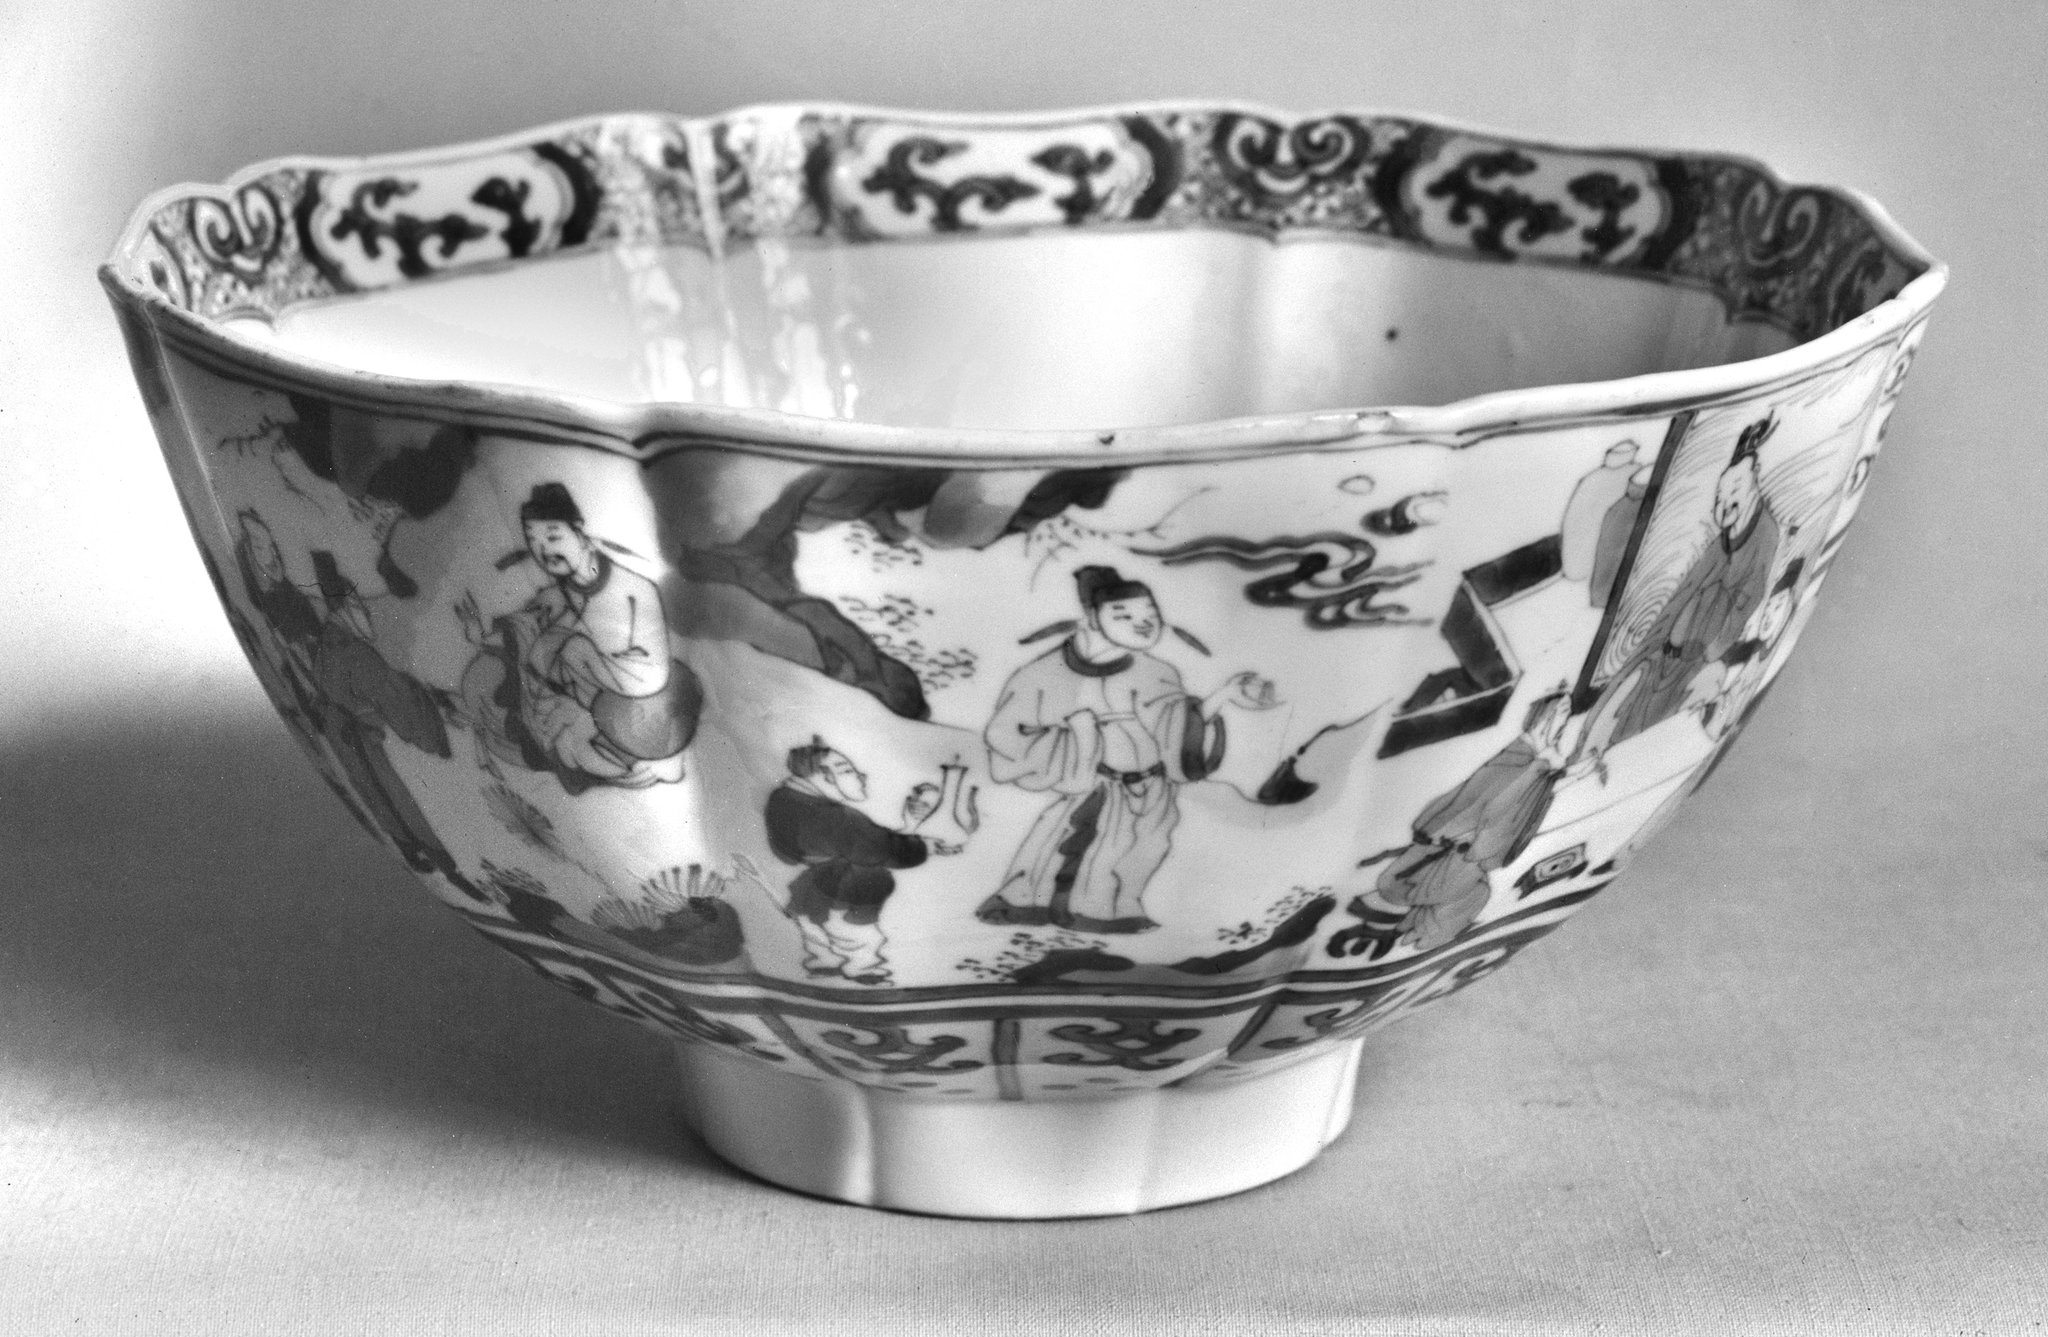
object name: bowl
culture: chinese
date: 1662-1722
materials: porcelain